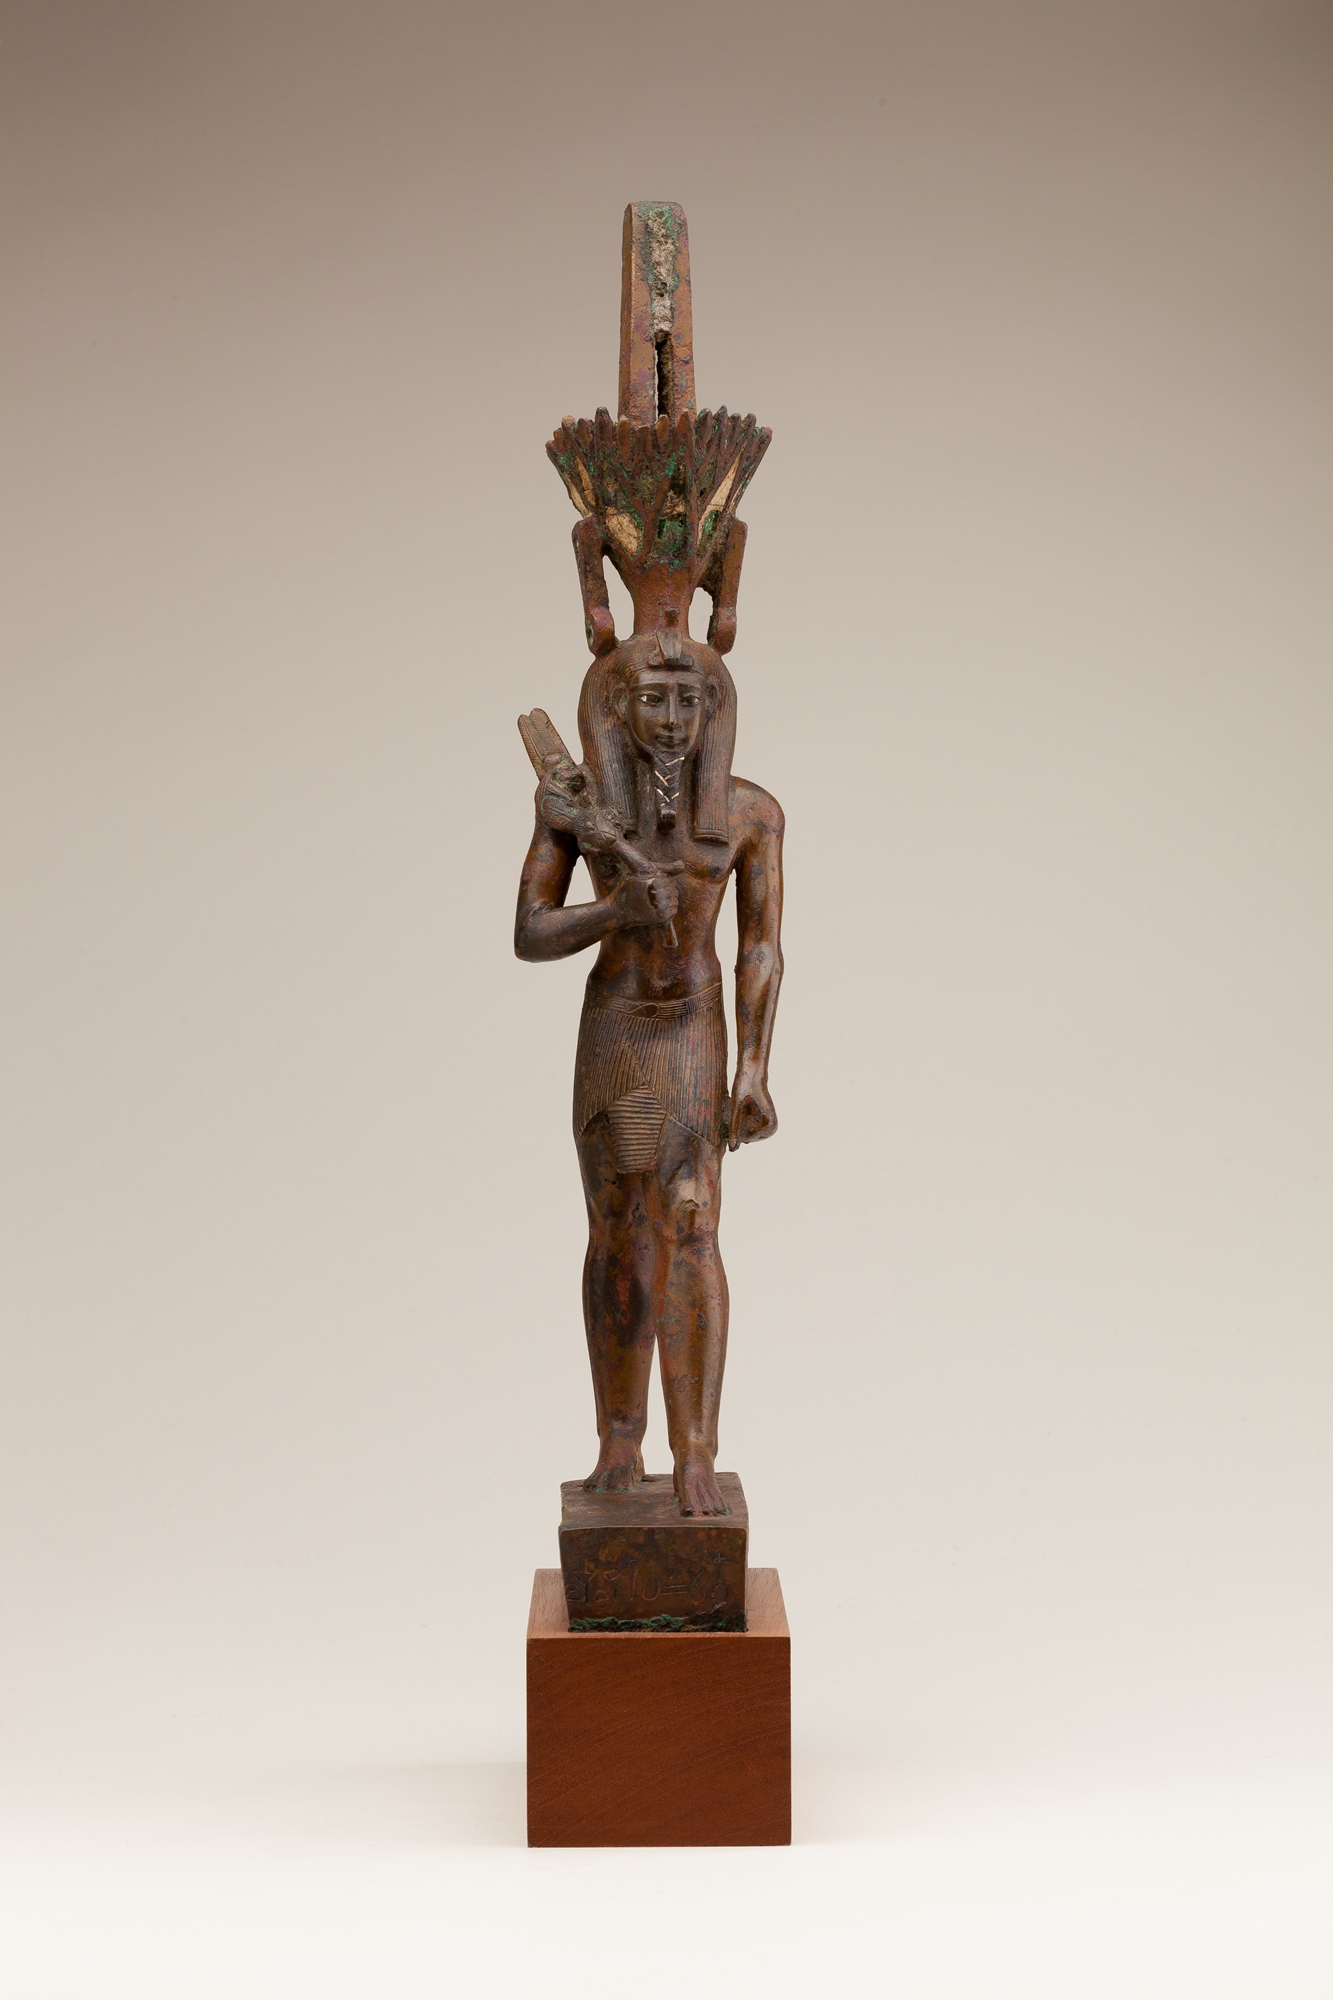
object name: statuette, nefertum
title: Statuette of Nefertum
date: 750-600 BCE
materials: alloy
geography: egypt